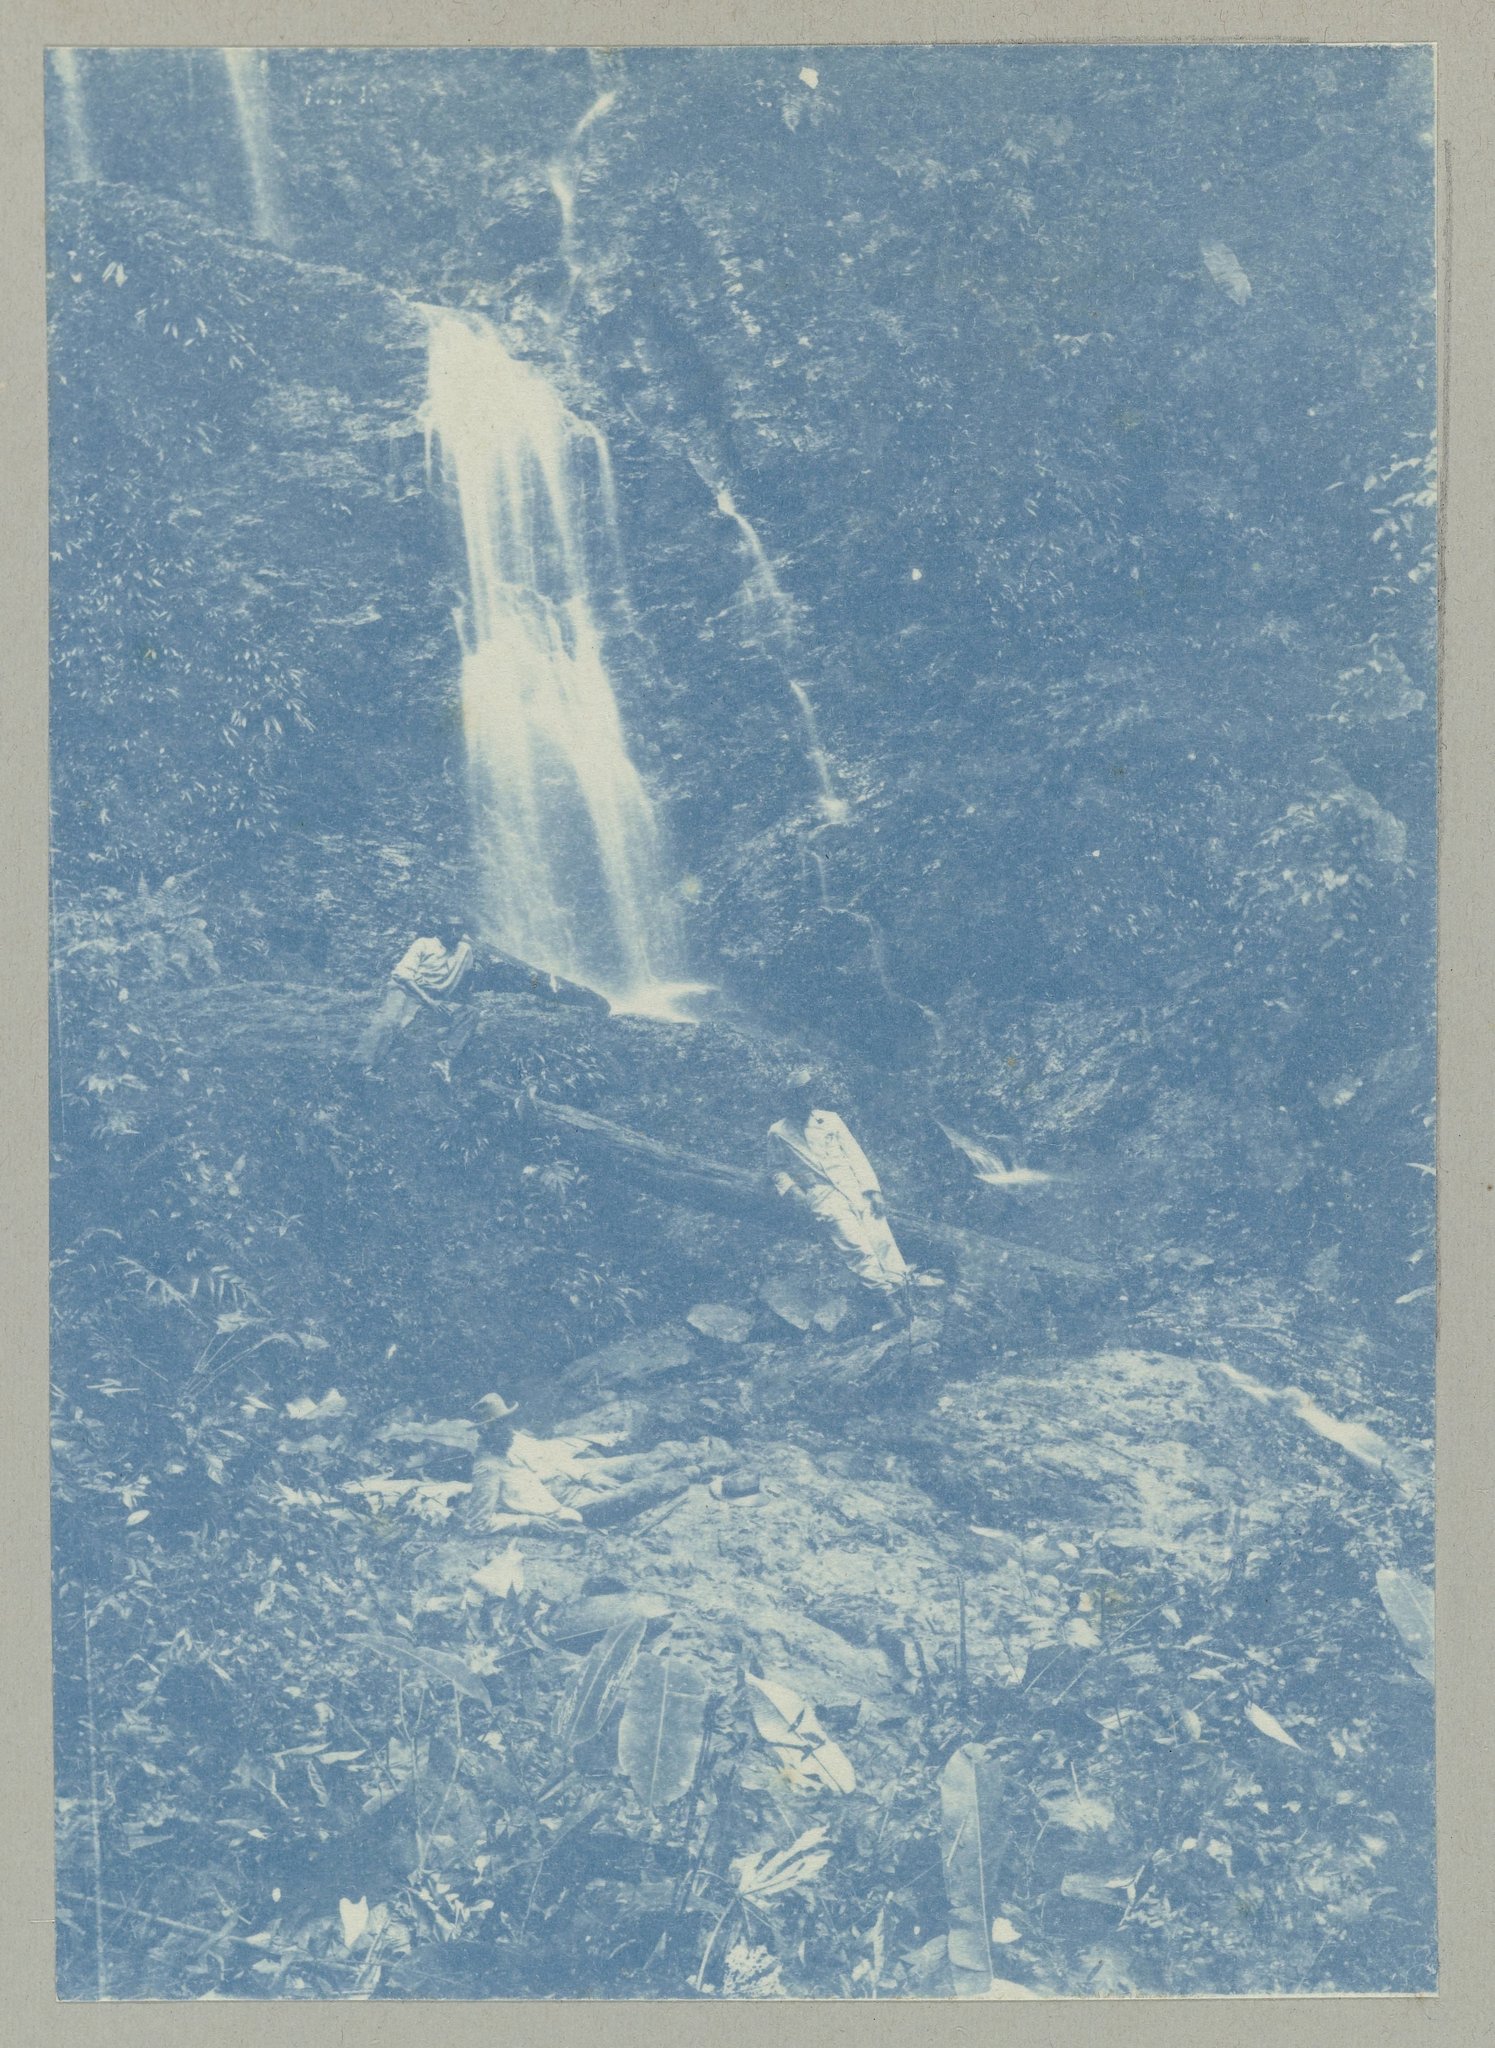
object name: photograph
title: Voet waterval Montanamijn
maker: hendrik doijer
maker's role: engineer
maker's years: 1863-1925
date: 1903-1910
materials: photographic support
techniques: cyanotype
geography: suriname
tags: suriname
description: Enkele mannen poserend bij een waterval bij de Montana-mijn. Onderdeel van het fotoalbum Souvenir de Voyage (deel 2), over het leven van de familie Doijer in en rond de plantage Ma Retraite in Suriname in de jaren 1903-1910.